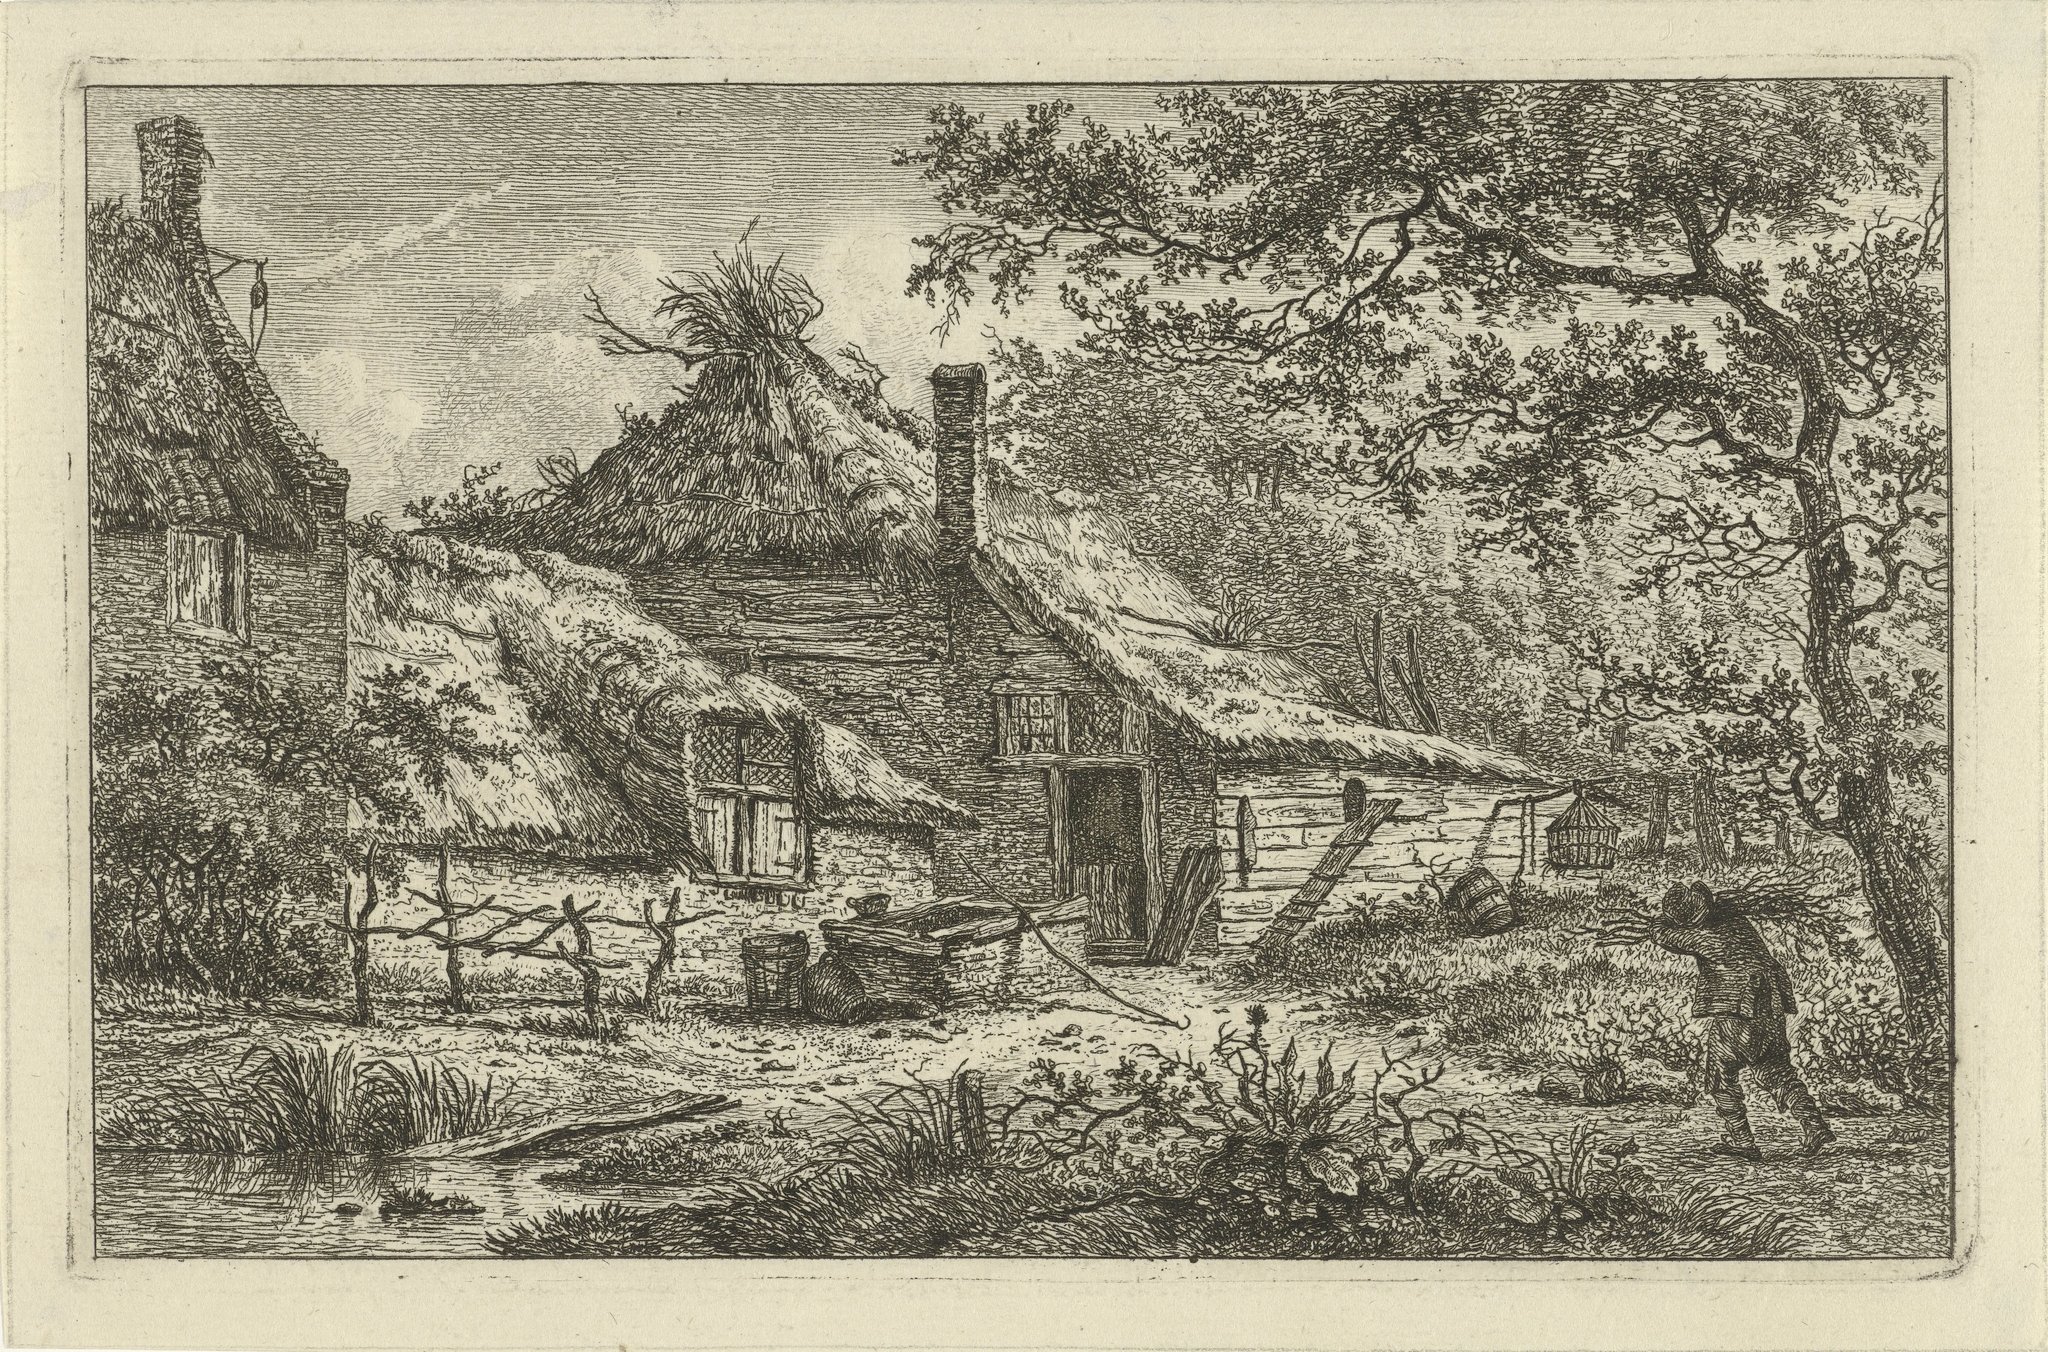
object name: print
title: Boerenerf met man met sprokkelhout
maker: hermanus fock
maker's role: conservator, draughtsman, painter, print maker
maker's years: 1766-1822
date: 1781-1822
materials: paper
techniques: etching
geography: amsterdam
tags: woodgathering, woodgatherer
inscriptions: collector's mark: Lugt 2228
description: Een gezicht op een boerenerf met een waterput. Onder de boom op de voorgrond loopt een man met een bos takken op zijn schouder.